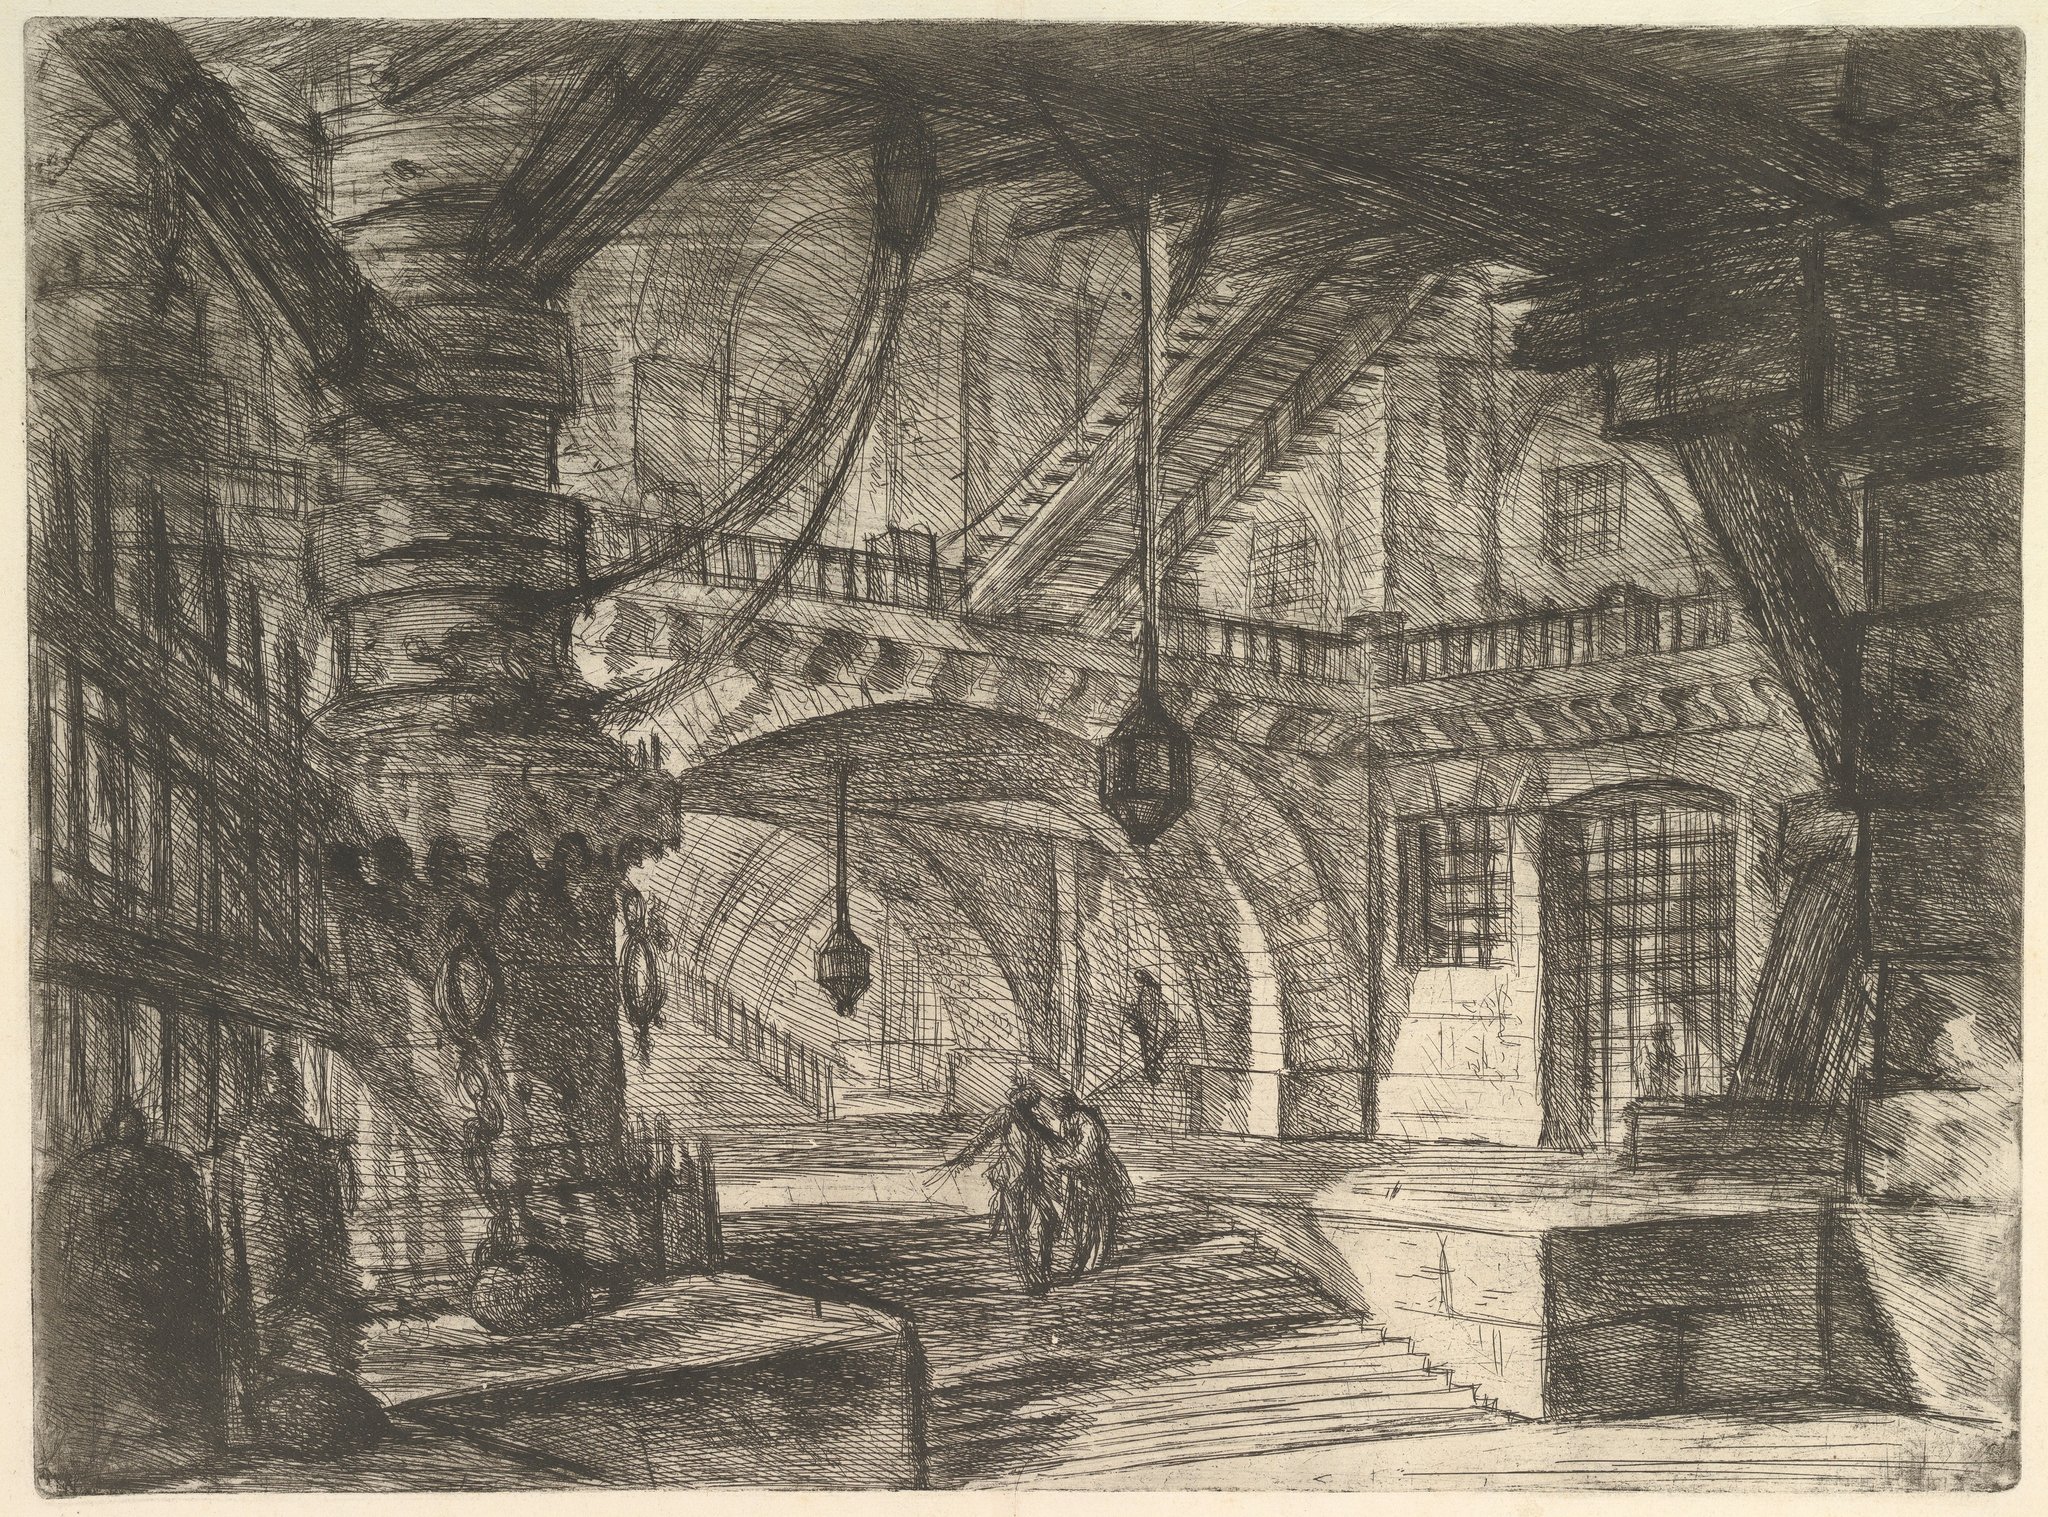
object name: print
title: The Pier with Chains, from "Carceri d'invenzione" (Imaginary Prisons)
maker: giovanni battista piranesi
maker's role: artist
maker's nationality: italian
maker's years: 1720-1778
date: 1749-1750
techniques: burnishing, engraving, etching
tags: human figures,prisons